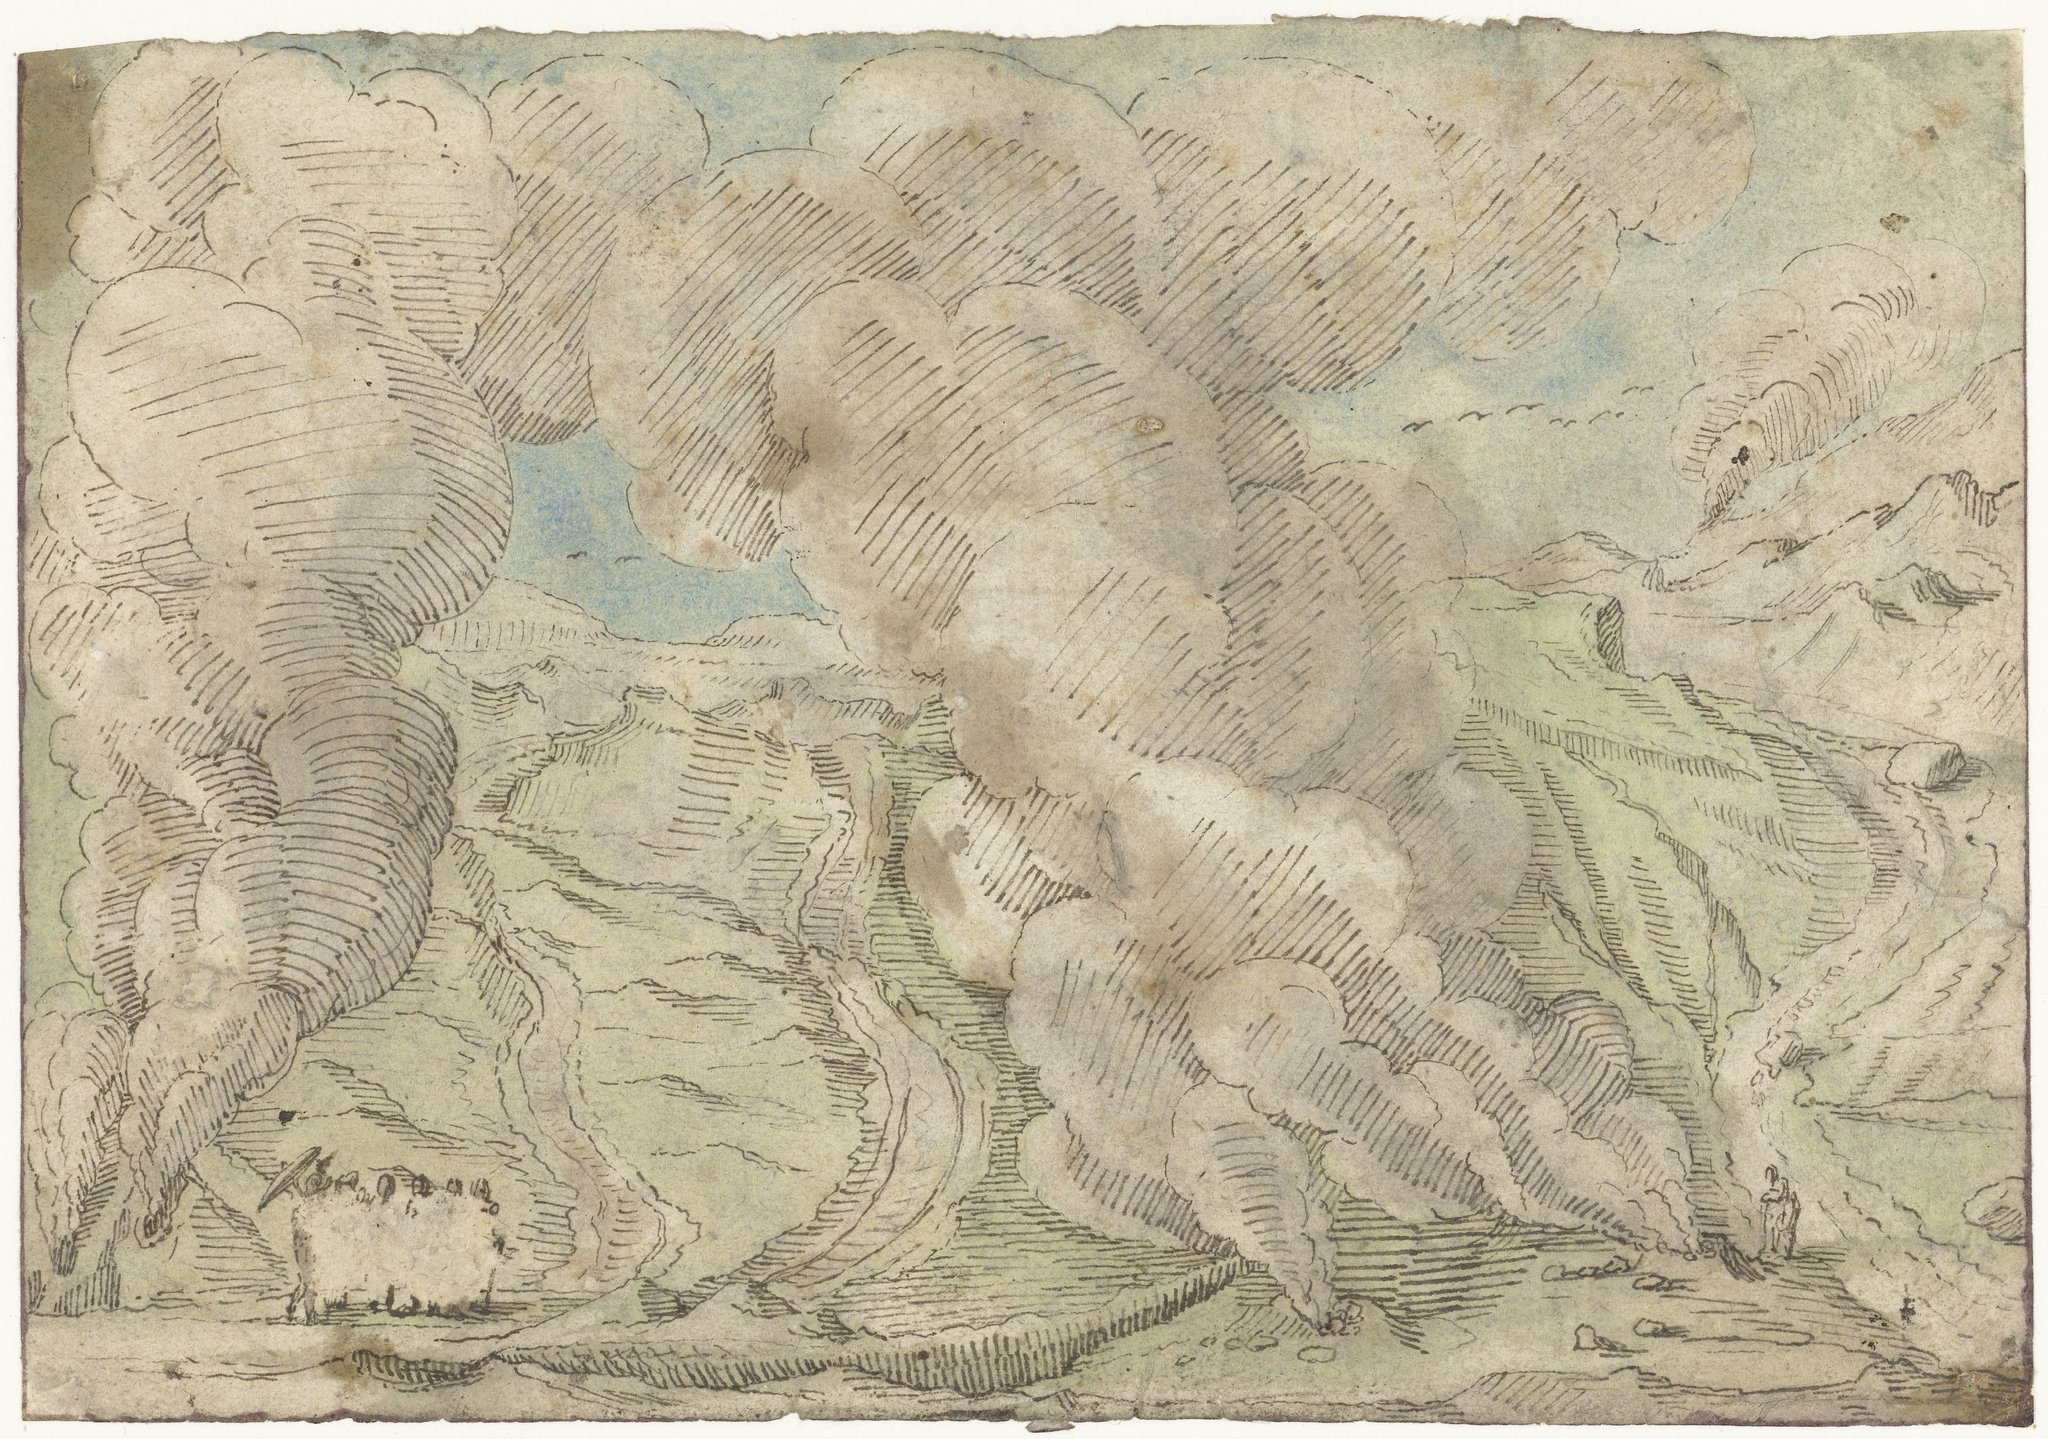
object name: drawing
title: Gezicht op de Solfatara bij Pozzuoli, buiten Napels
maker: gerard ter borch (i)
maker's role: draughtsman, print maker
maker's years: 1584-1662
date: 1611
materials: ink, paper, watercolor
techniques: brush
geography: naples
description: Gezicht op de Solfatara bij Pozzuoli. Het papier is linksonder over de figuren afgesleten. Op de achterkant van het blad staan penseelstreekjes in bruin, groen en blauw.